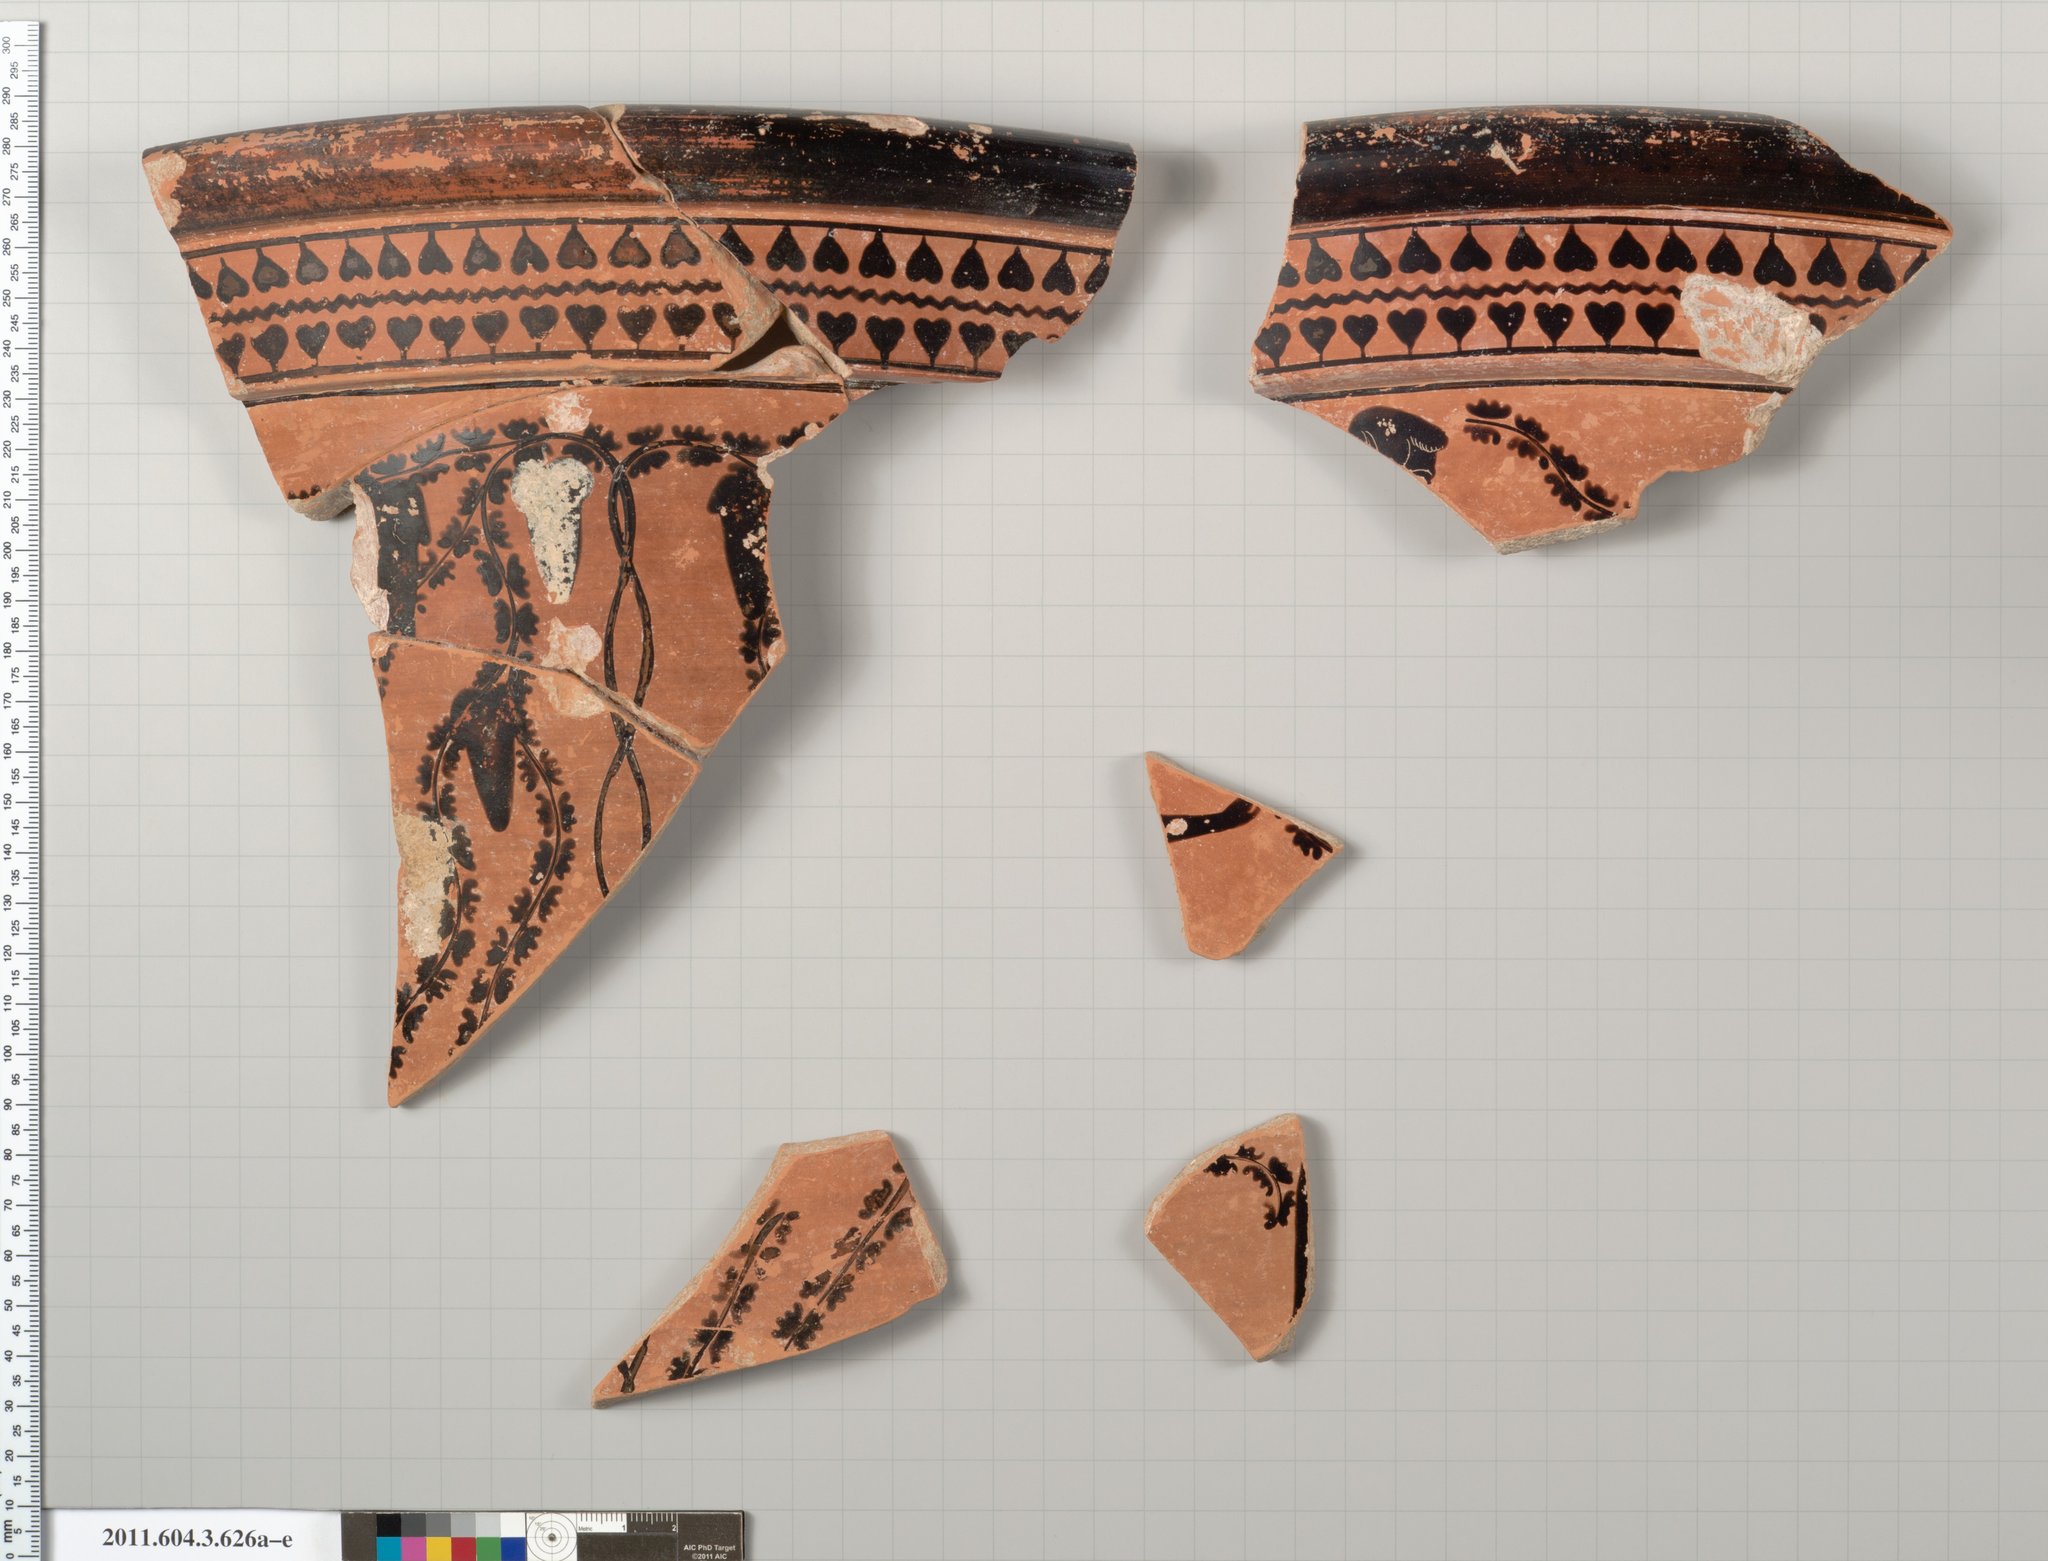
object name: calyx krater fragment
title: Terracotta fragments of a calyx-krater (bowl for mixing wine and water)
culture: greek, attic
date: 525-501 BCE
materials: terracotta